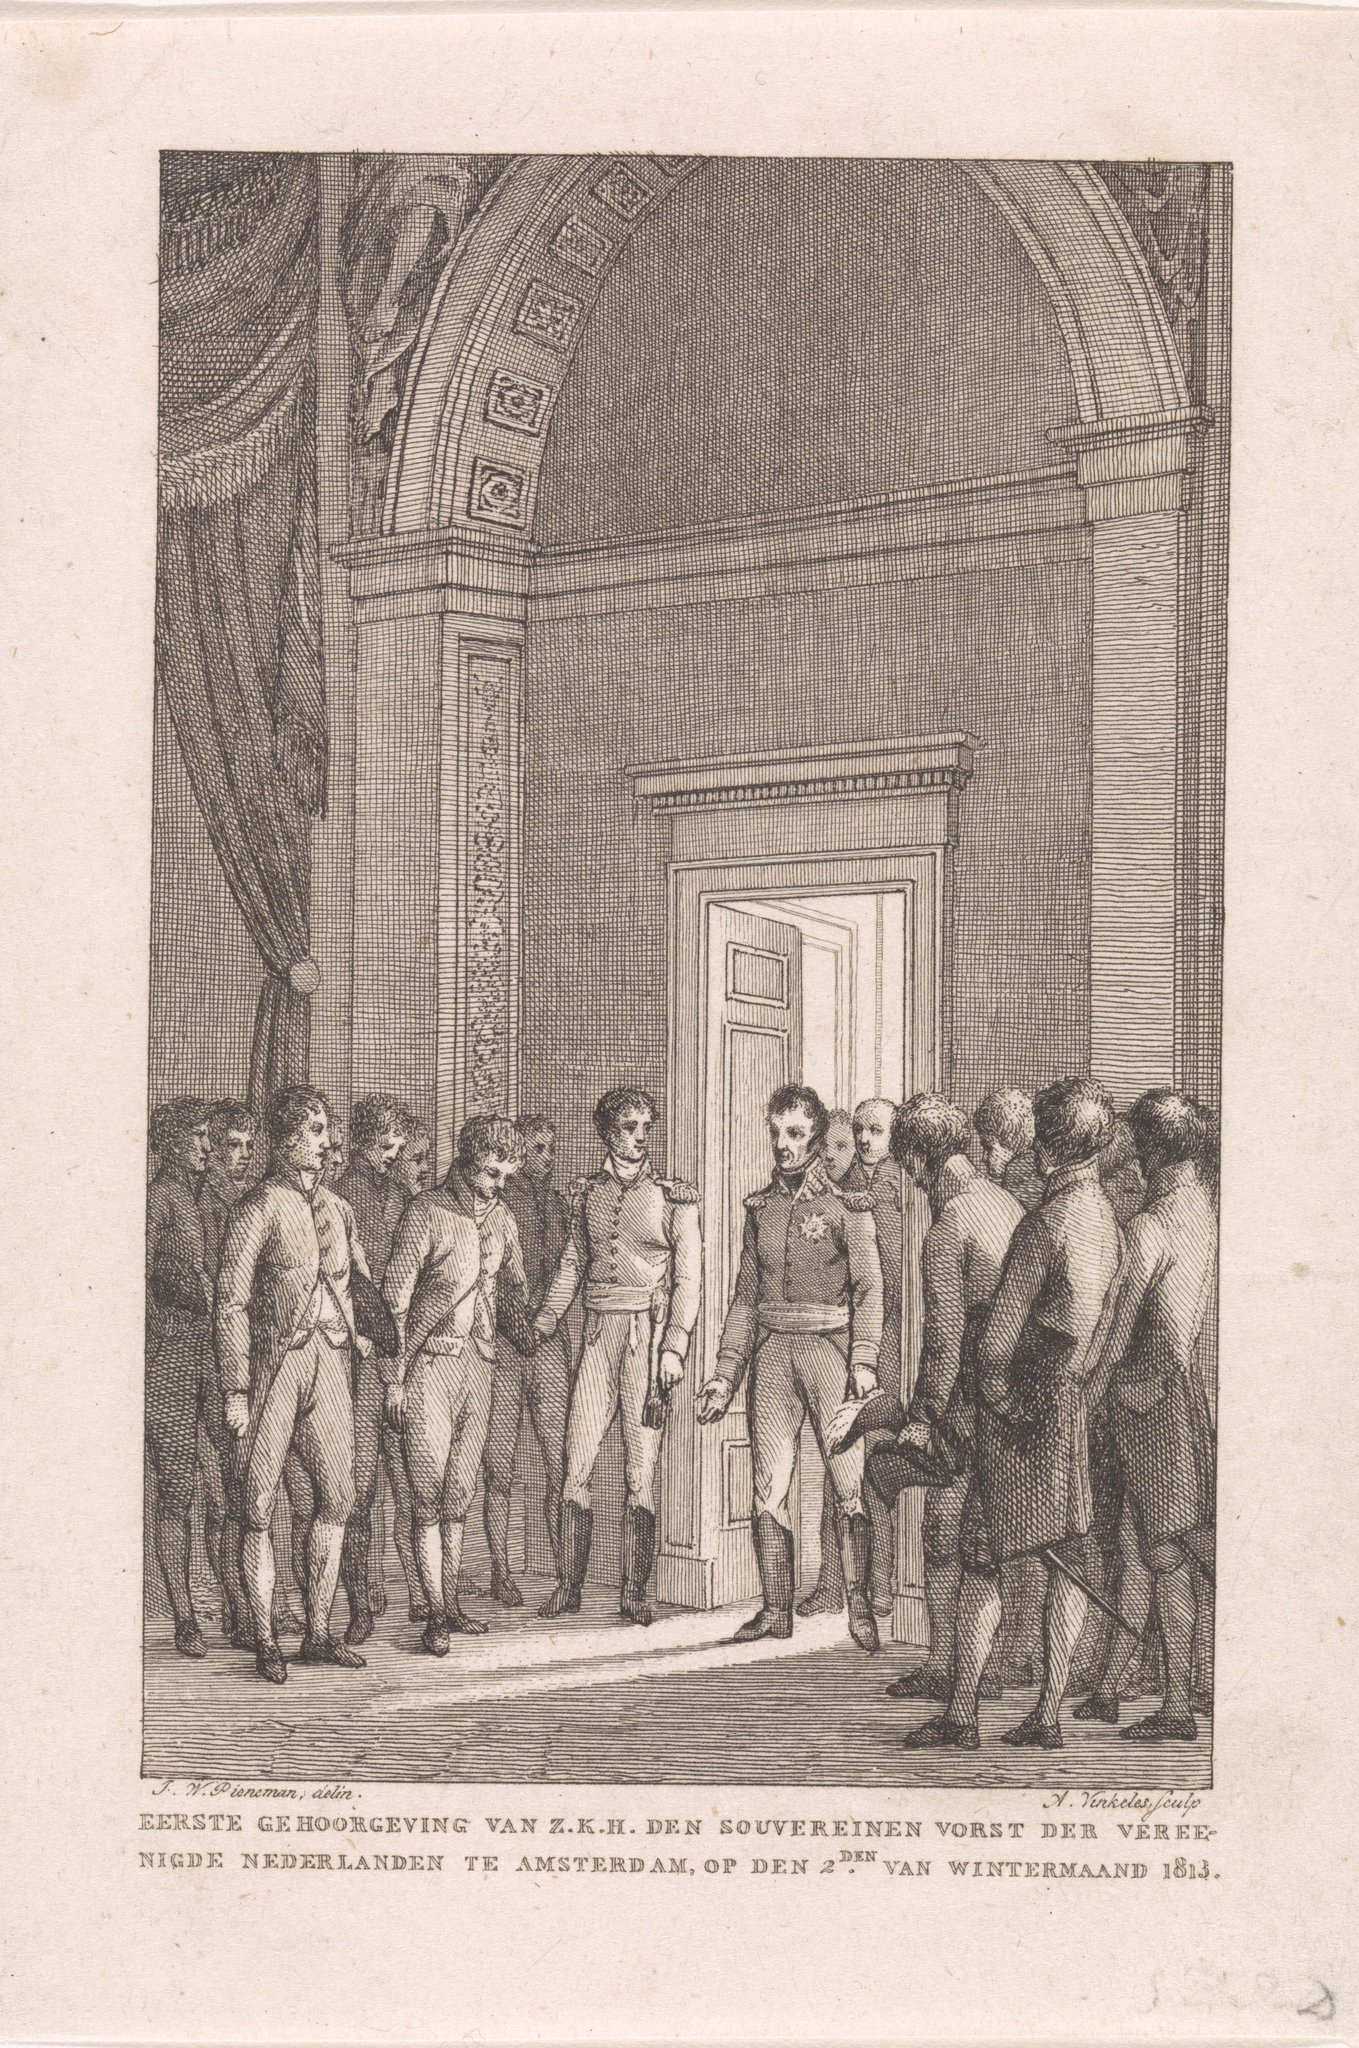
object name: book illustration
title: Eerste gehoorgeveing van Z.K.H. den soevereinen vorst der vereenigde nederlanden te Amsterdam, op den 2den van wintermaand 1813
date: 1814-1816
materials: paper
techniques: etching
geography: the hague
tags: the hague, berlin, william i of the netherlands, landing of william frederick i (1813)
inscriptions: collector's mark: Lugt 2228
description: Prent gebruikt als boekillustratie in: Konijnenburg, J. Nationaal gedenkboek der hernieuwde Nederlandsche unie, van den jare 1813. Den Haag: Johannes Allart, 1816.